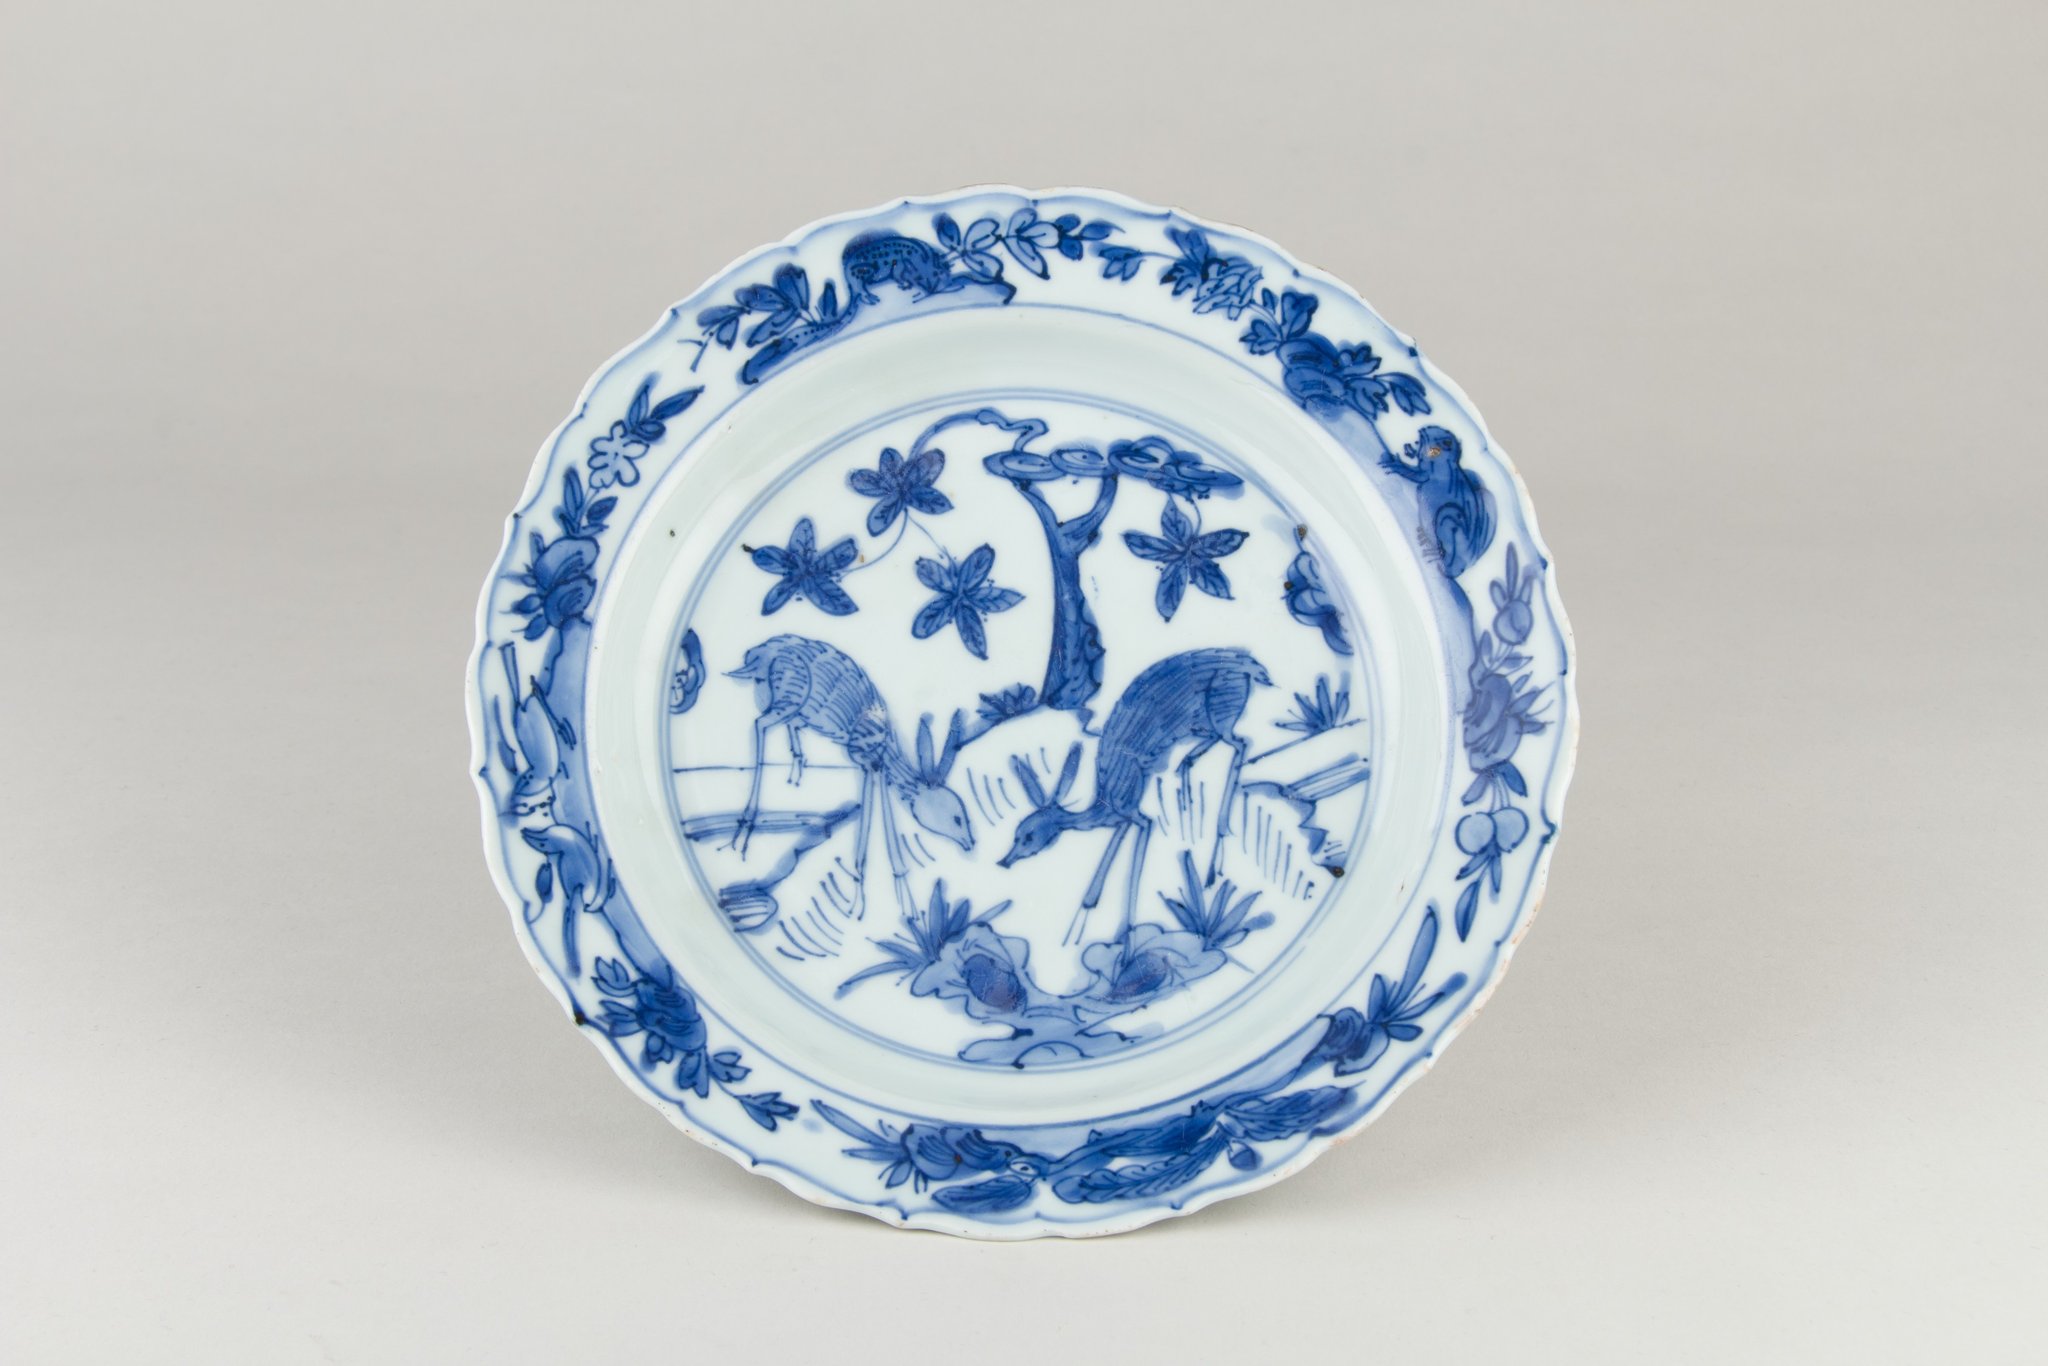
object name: plate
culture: chinese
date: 1368-1644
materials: porcelain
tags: deer,leaves,trees